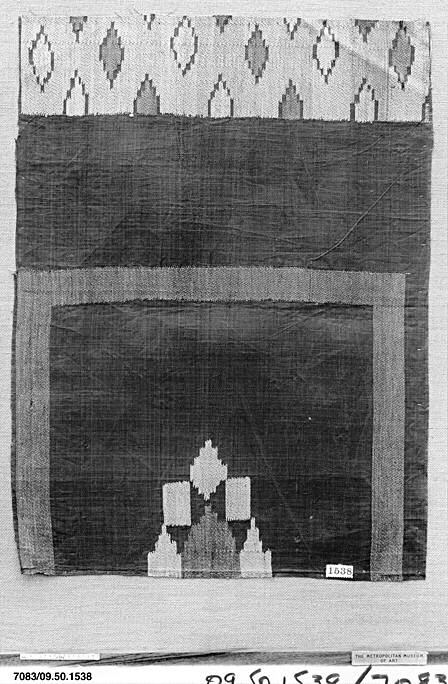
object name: textile fragment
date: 1701-1800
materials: silk, silver, thread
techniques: brocade, weave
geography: turkey